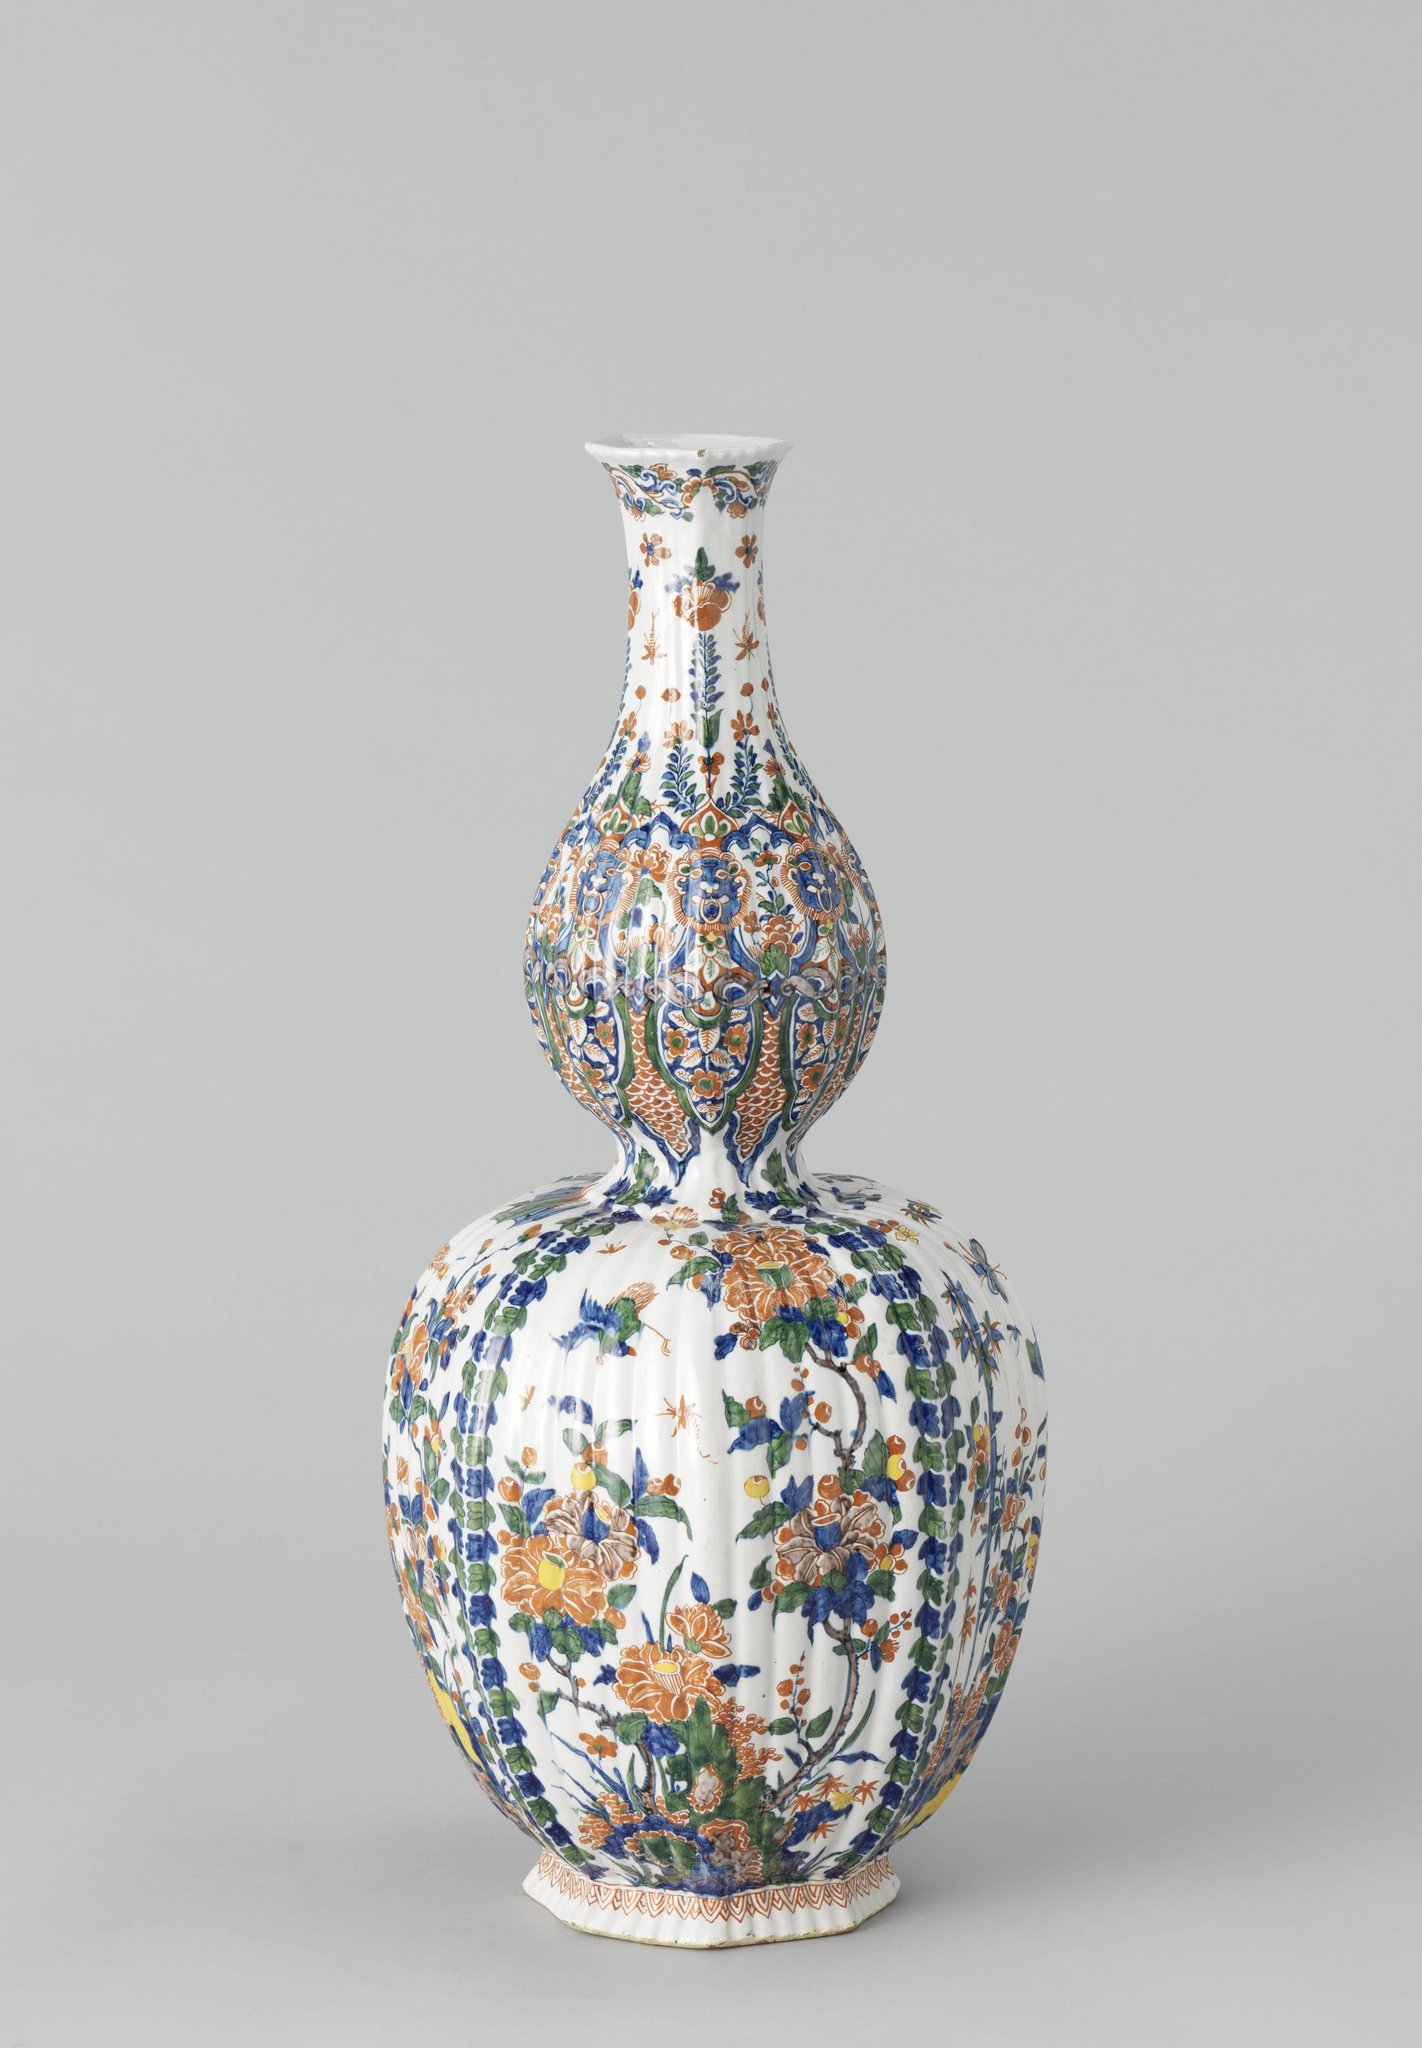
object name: bottle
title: Fles van veelkleurig beschilderde faience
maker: Anonymous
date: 1695-1715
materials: earthenware, paint, glaze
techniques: firing, polychromy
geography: delft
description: Geribde, achthoekige veelkleurig beschilderde fles. Onderdeel van een kaststel bestaande uit vijf delen.